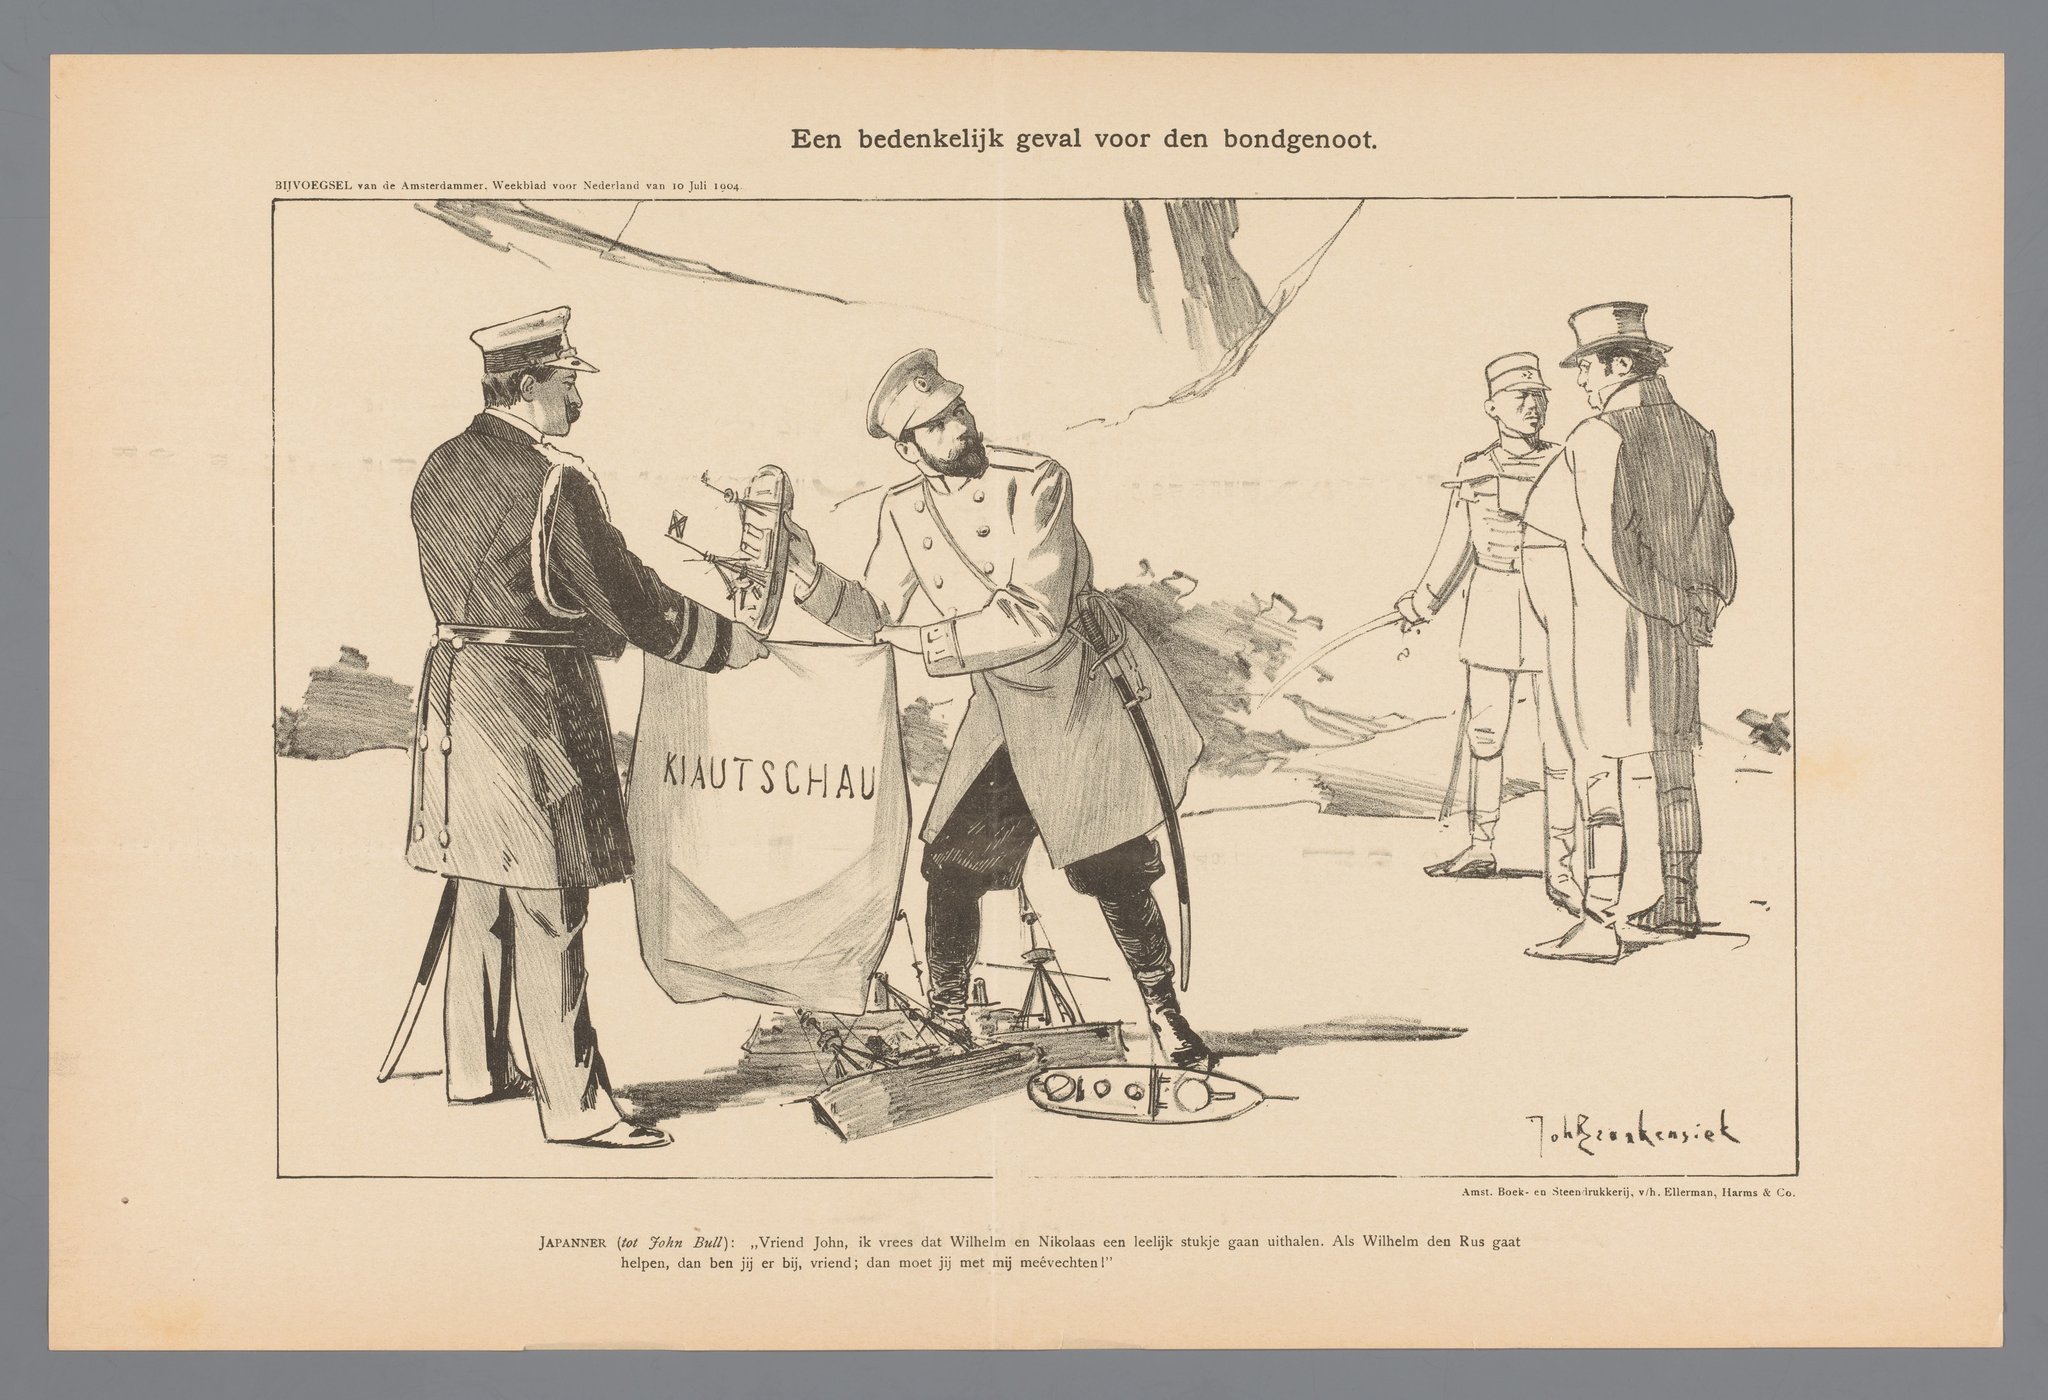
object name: cartoon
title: Een bedenkelijk geval voor den bondgenoot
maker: johan braakensiek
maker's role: draughtsman, print maker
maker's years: 1858-1940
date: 1904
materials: paper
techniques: lithograph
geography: amsterdam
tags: wilhelm ii (keizer van duitsland), historical persons, emperor, personifications of countries, nations, states, districts, etc. (+ nation; national), political caricatures and satires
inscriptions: date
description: Prent uit het bijvoegsel van: De Amsterdammer. Weekblad voor Nederland, 10 juli 1904.